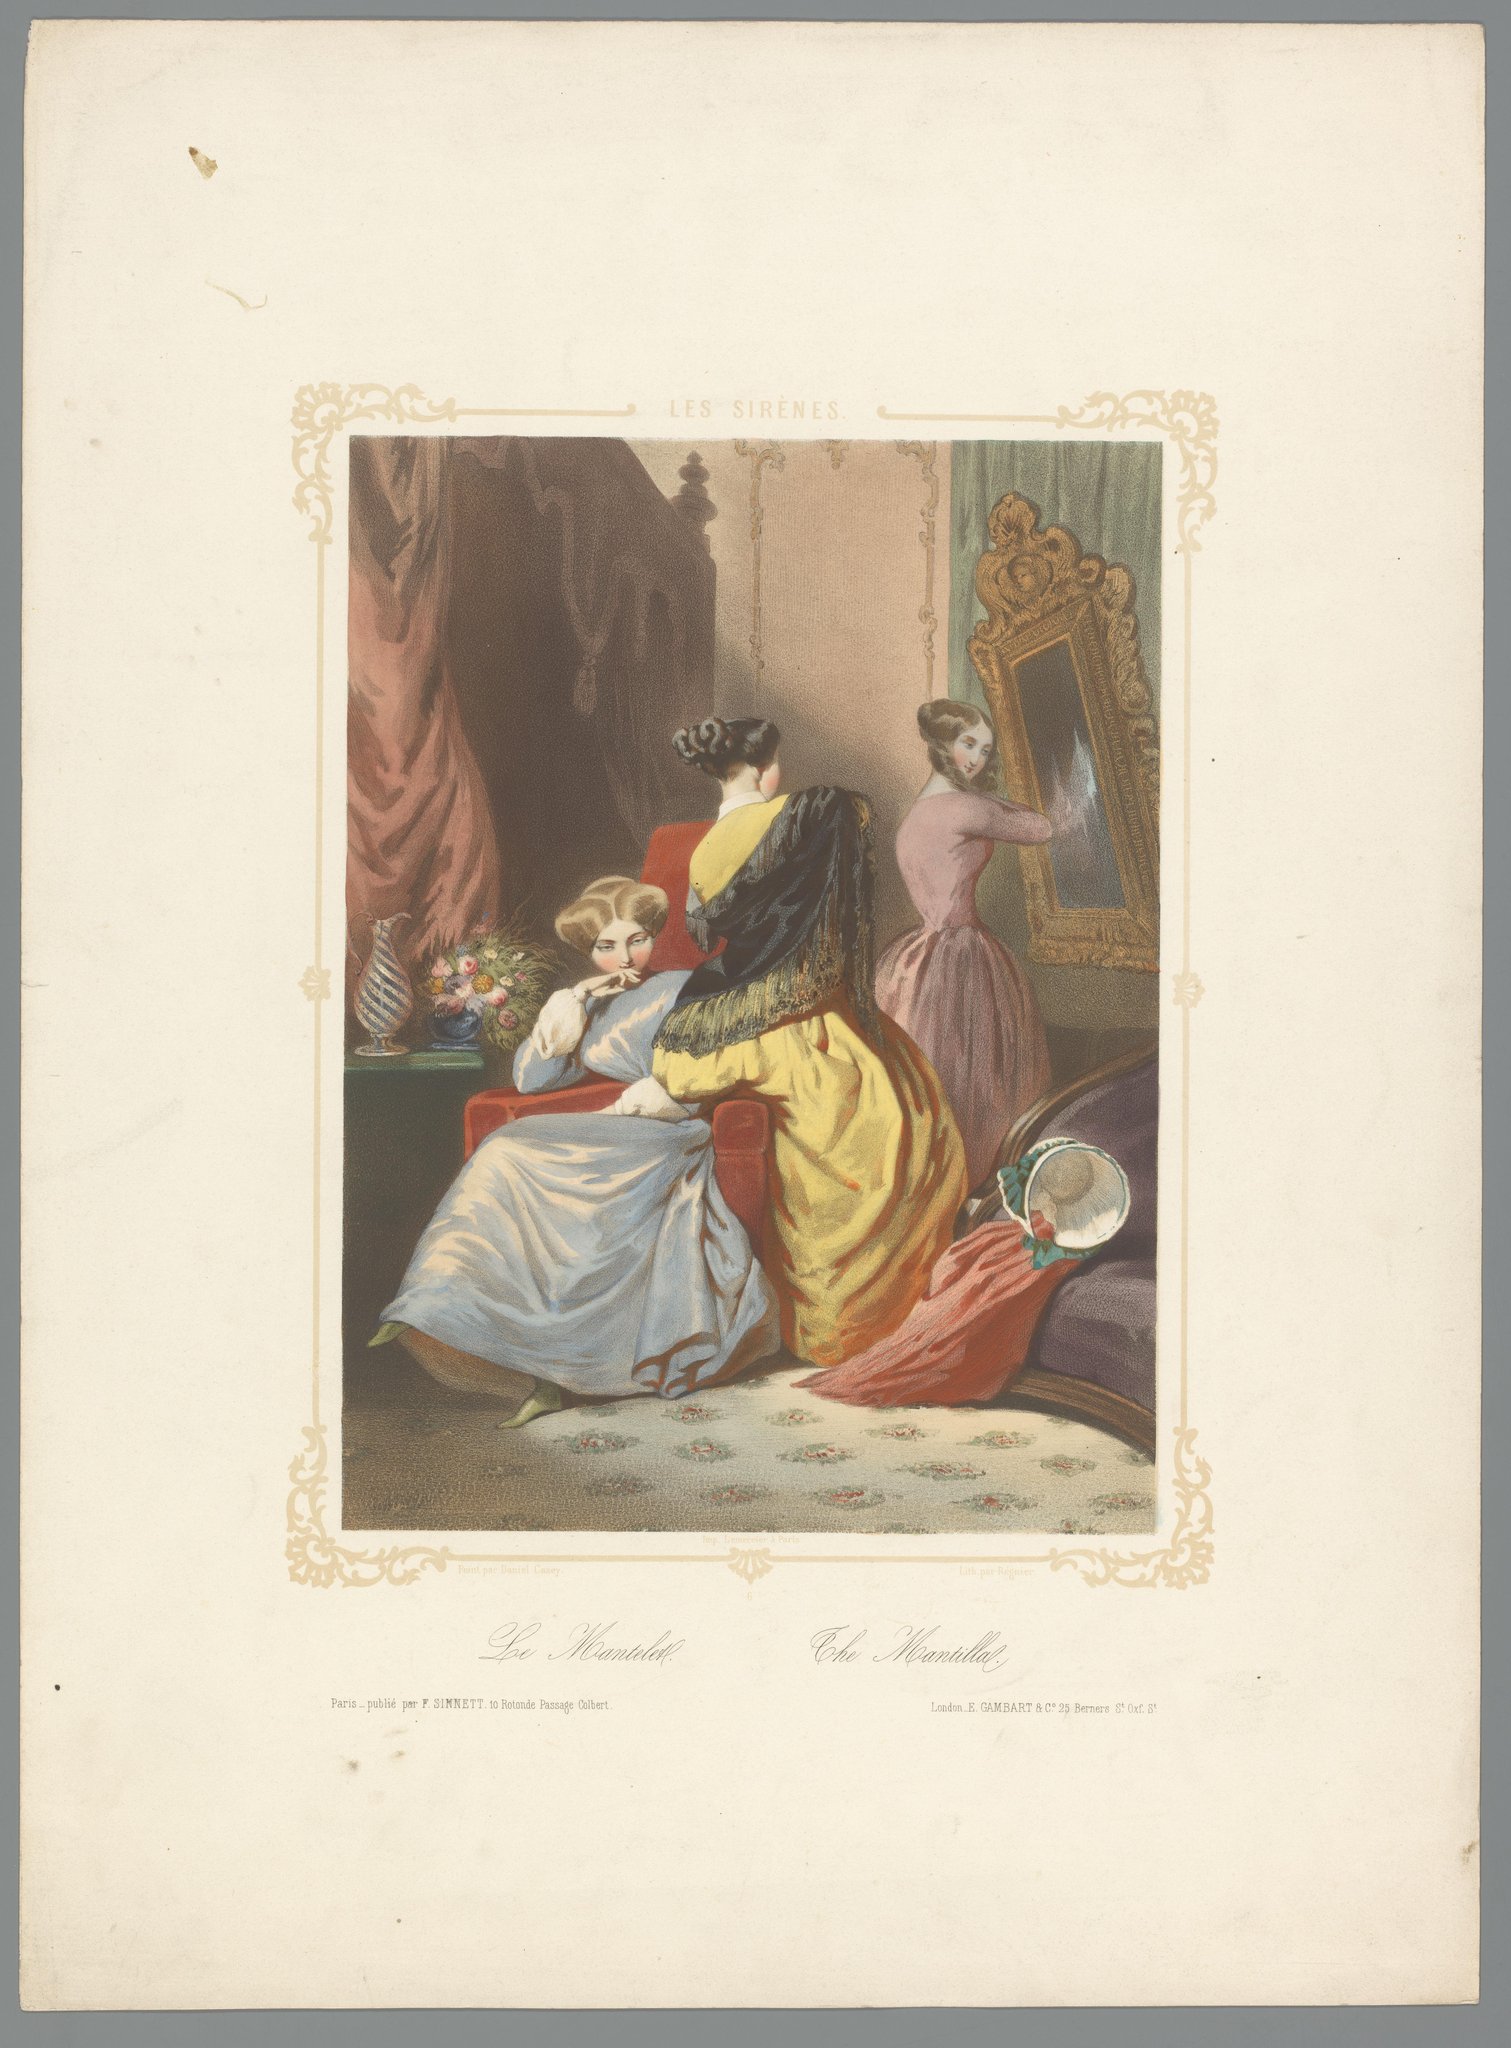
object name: print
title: Les sirènes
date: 1851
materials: paper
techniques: hand coloring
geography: paris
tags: adult woman, neck-gear ~ clothing (shawl) (+ women's clothes)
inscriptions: collector's mark: Lugt 2228